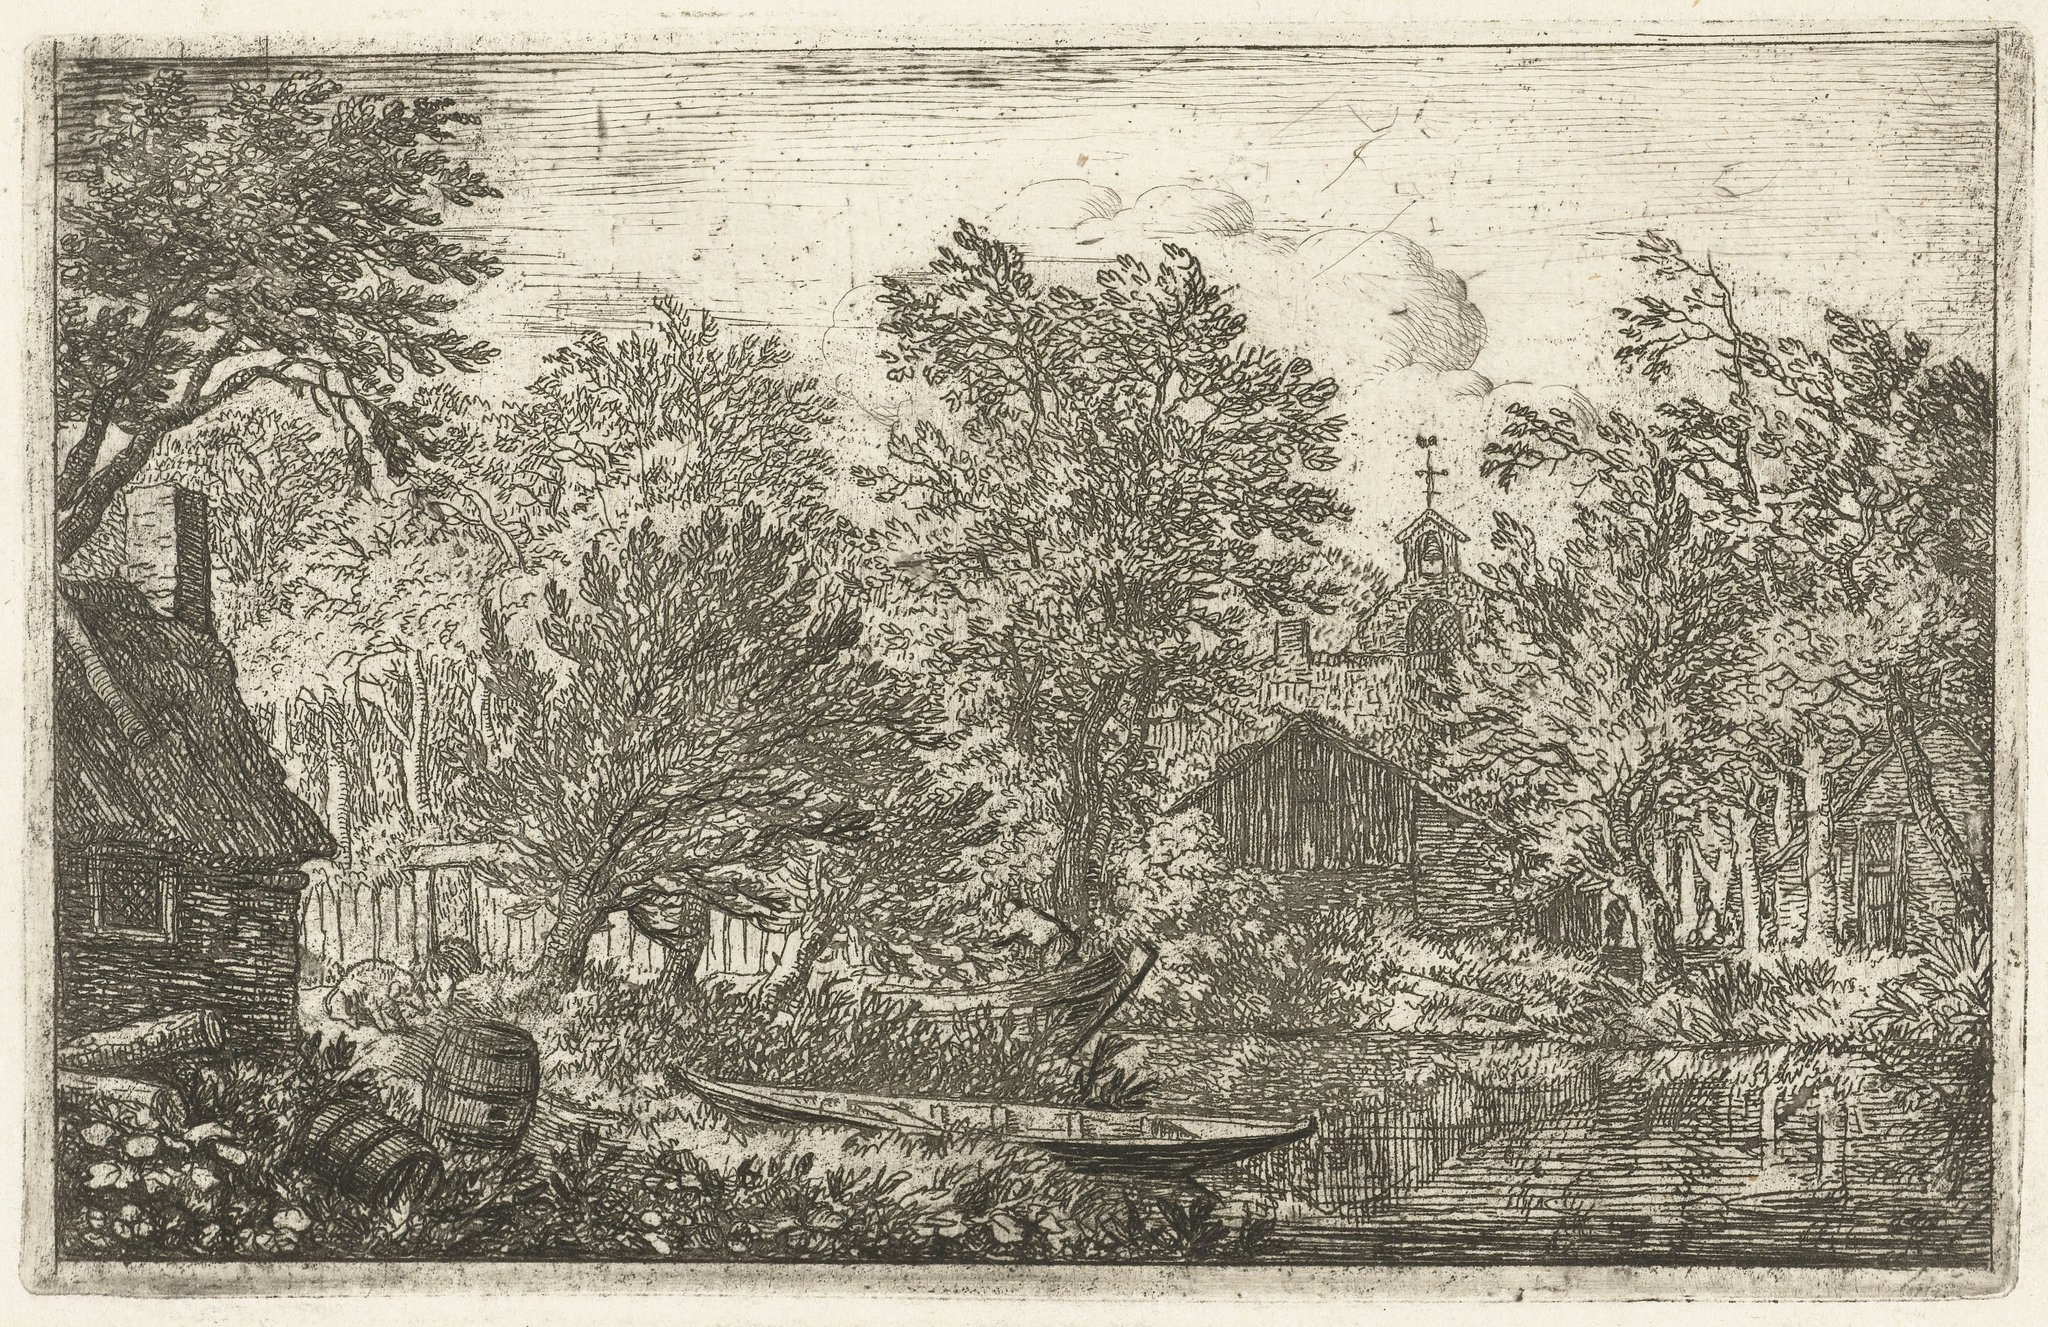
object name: print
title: Dorpsgezicht met roeiboot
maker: allaert van everdingen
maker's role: draughtsman, painter, print maker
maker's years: 1621-1675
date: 1631-1675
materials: paper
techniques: etching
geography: netherlands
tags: canals, waters (in village)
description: Gezicht op huizen en bomen langs het water. Naast het huis op de voorgrond enkele houten tonnen en op de oever een roeiboot.